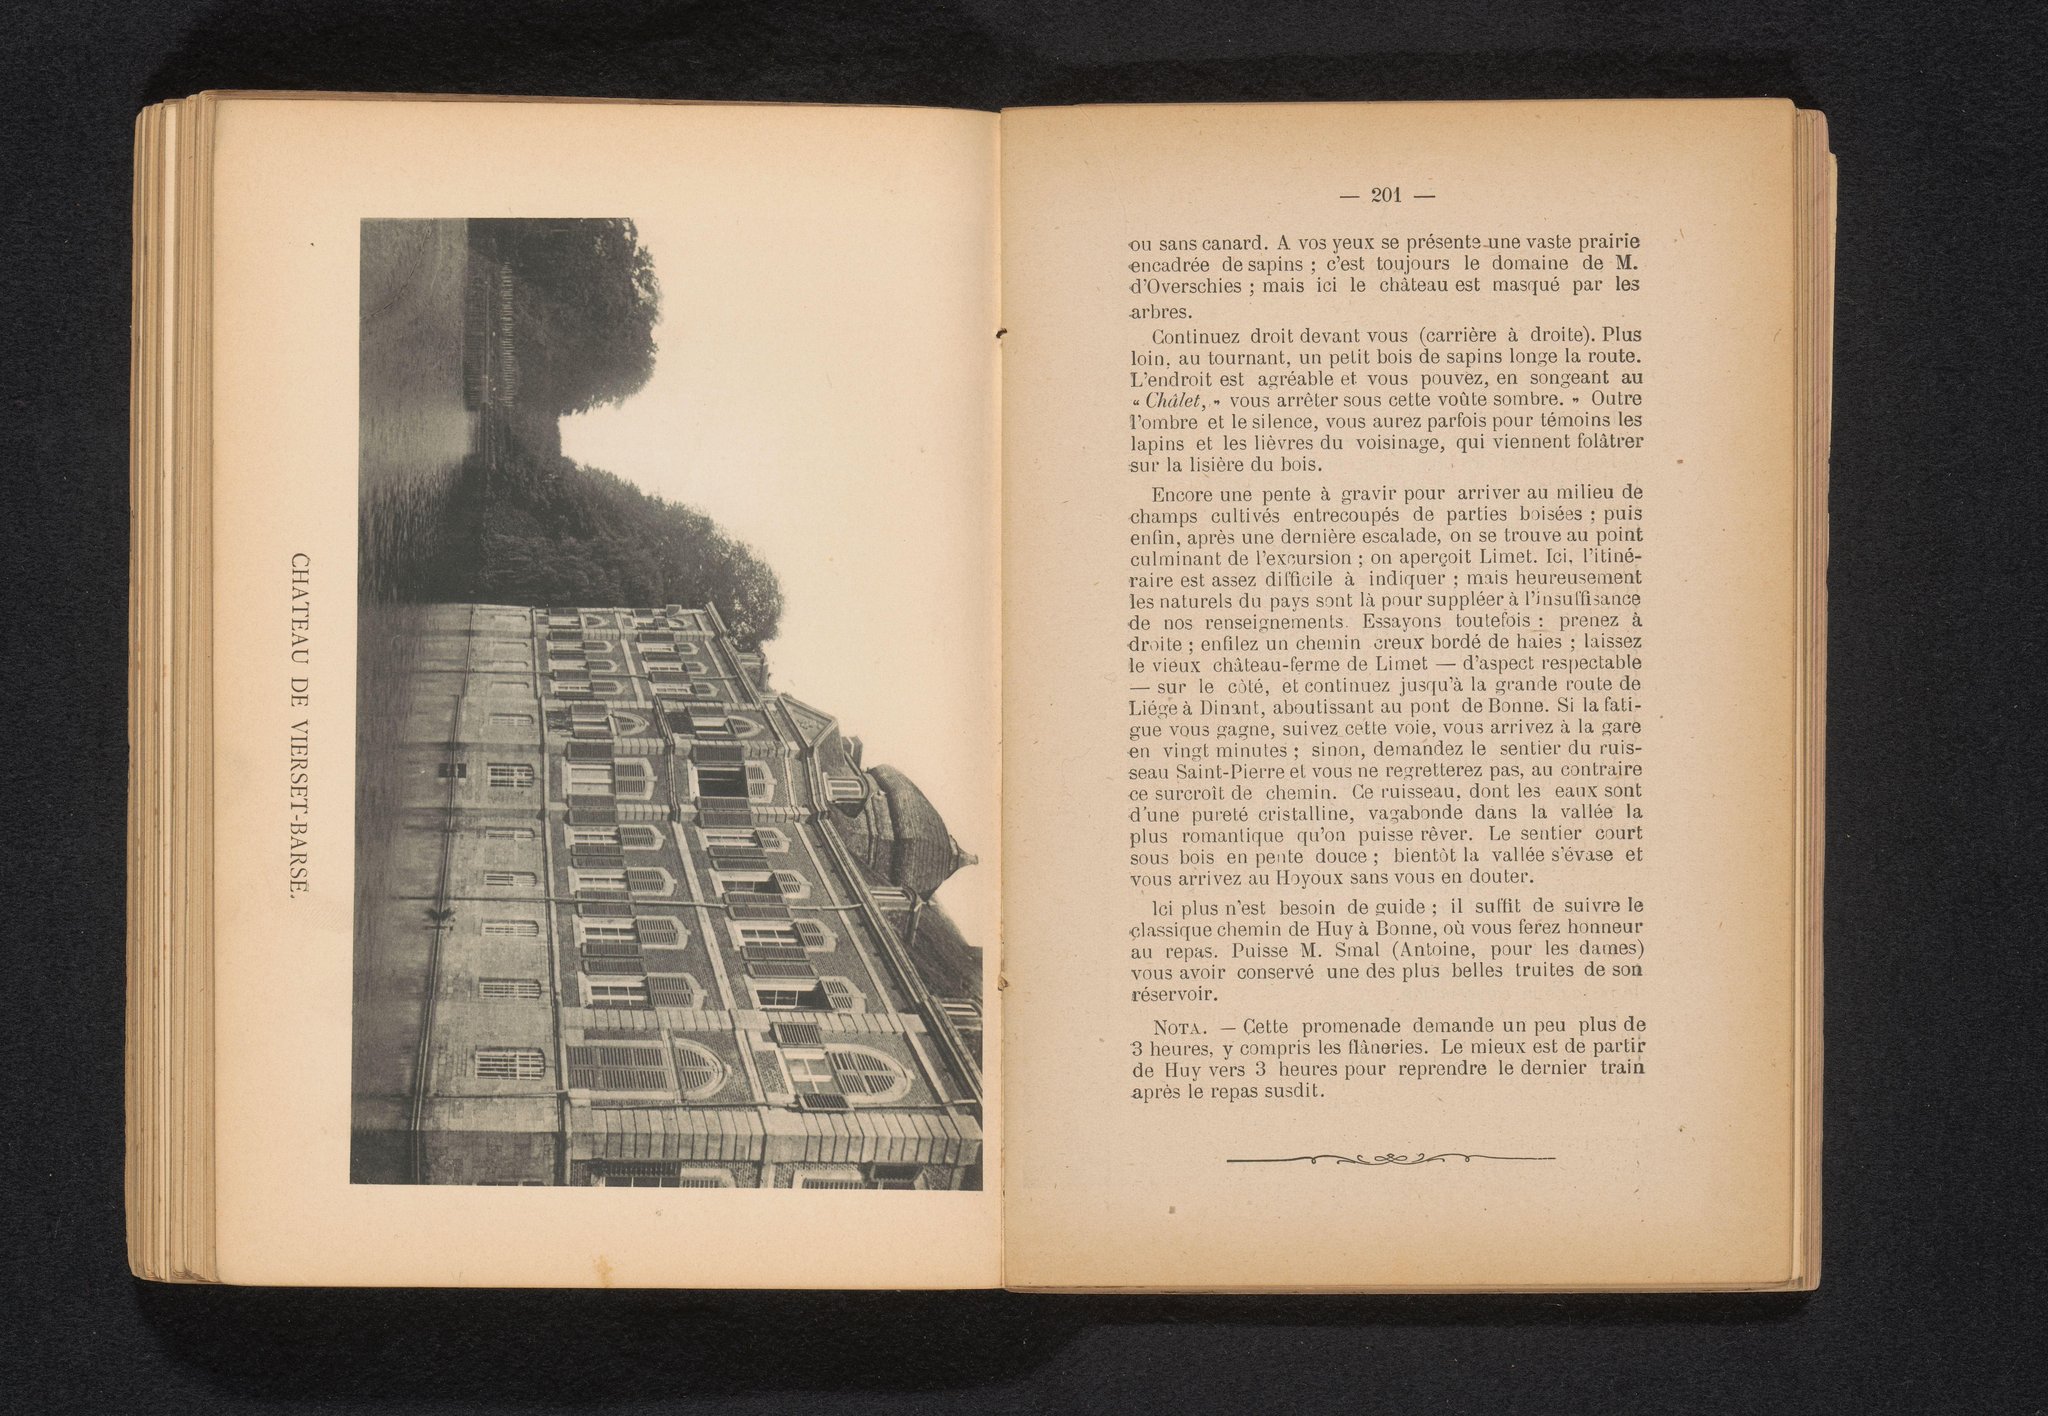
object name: photomechanical print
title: Gezicht op Château de Vierset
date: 1885-1890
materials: paper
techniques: photograph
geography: vierset-barse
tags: castle